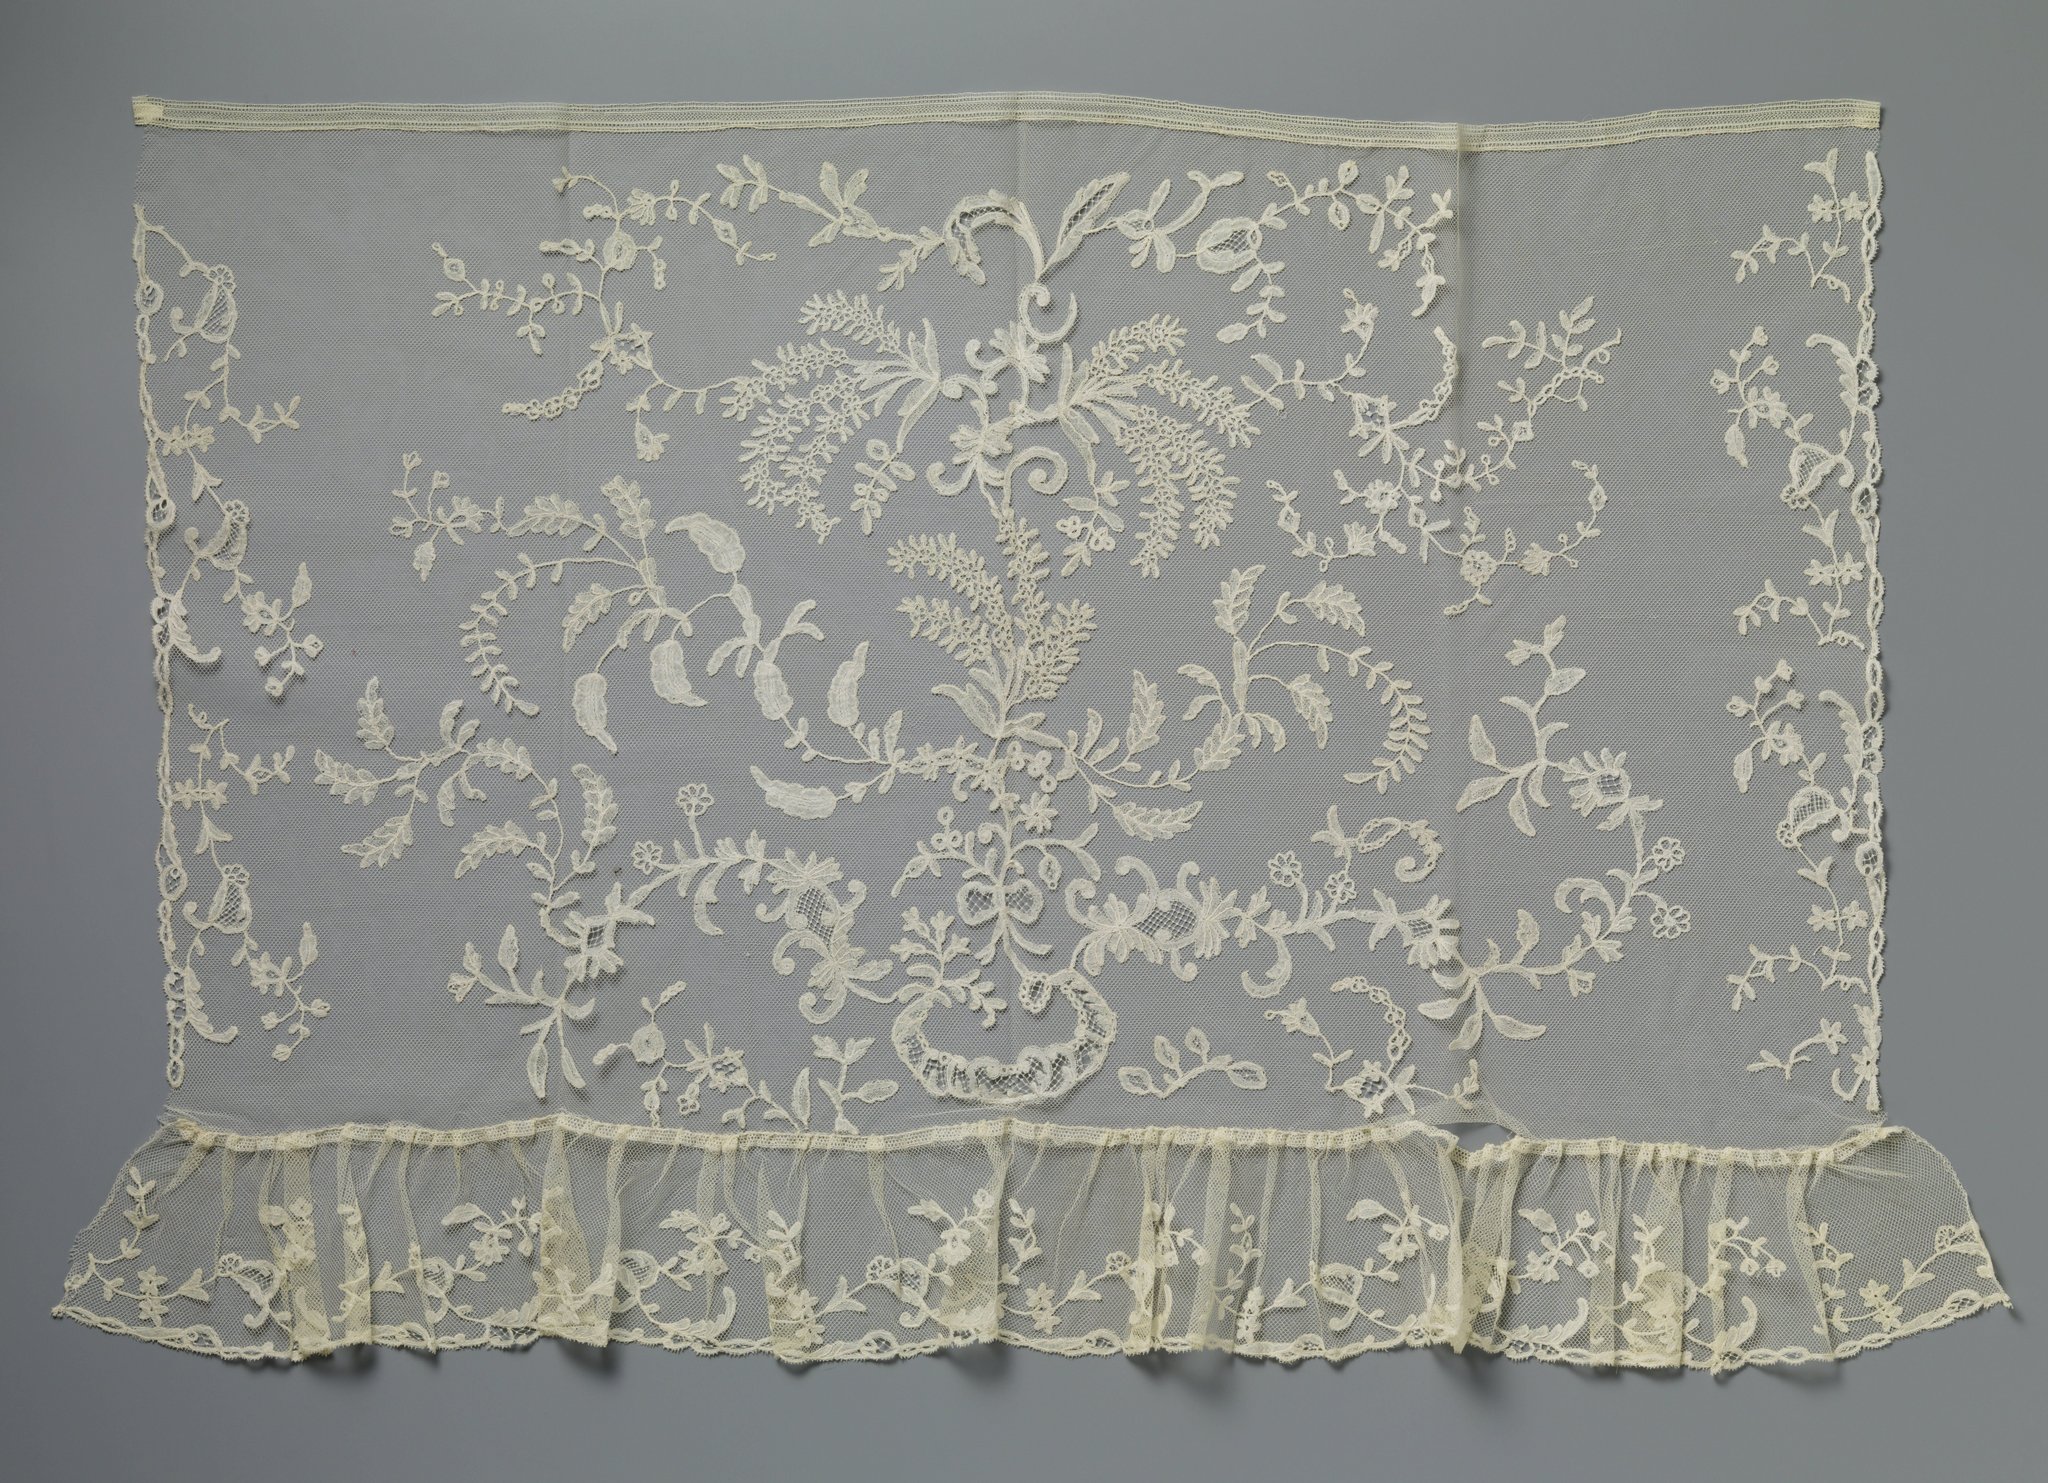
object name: strip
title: Strook applicatiekant met mimosatakjes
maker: Anonymous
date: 1890-1909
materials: linen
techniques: lace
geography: belgium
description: Strook naturelkleurige applicatiekant, kloskant geappliceerd op machinale tule. Het patroon vertoont een rij van naar rechts golvende mimosatakken. De strook is vastgenaaid aan BK-BR-J-255.